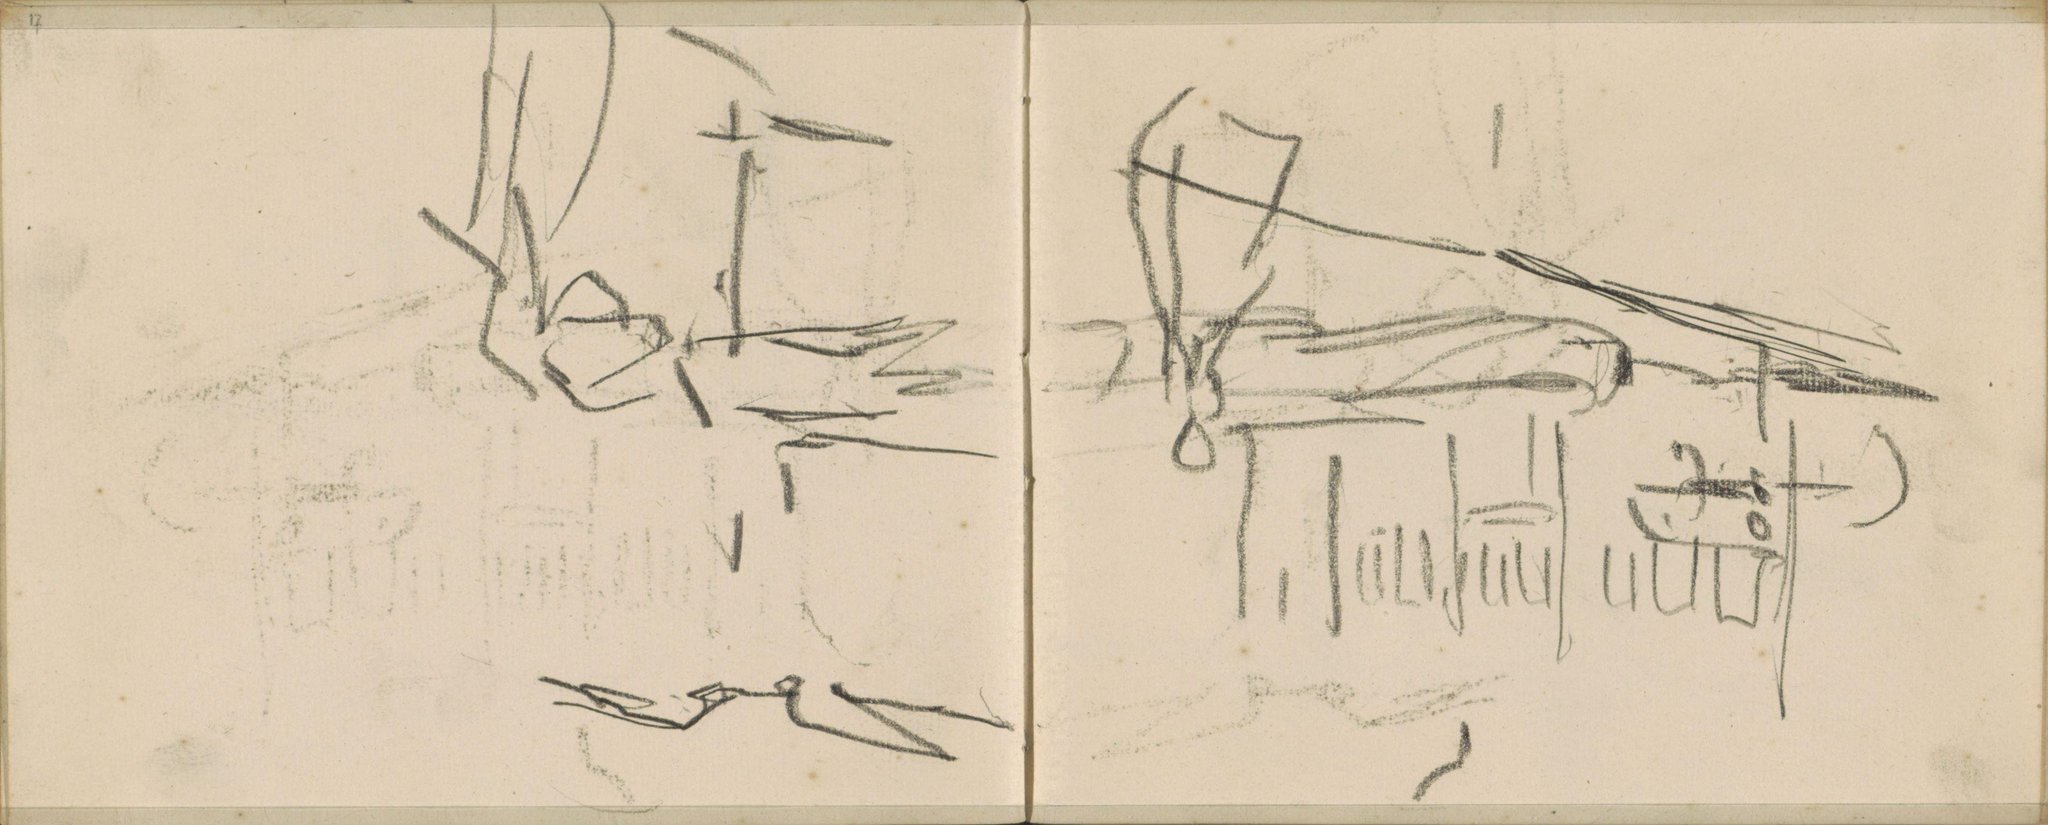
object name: sketchbook leaf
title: Figuren, mogelijk op straat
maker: george hendrik breitner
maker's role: draughtsman, painter, print maker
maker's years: 1857-1923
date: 1886-1903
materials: chalk, paper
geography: amsterdam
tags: street (+ city(-scape) with figures, staffage), amsterdam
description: Pagina 17 en pagina 18 uit een schetsboek met 27 bladen.